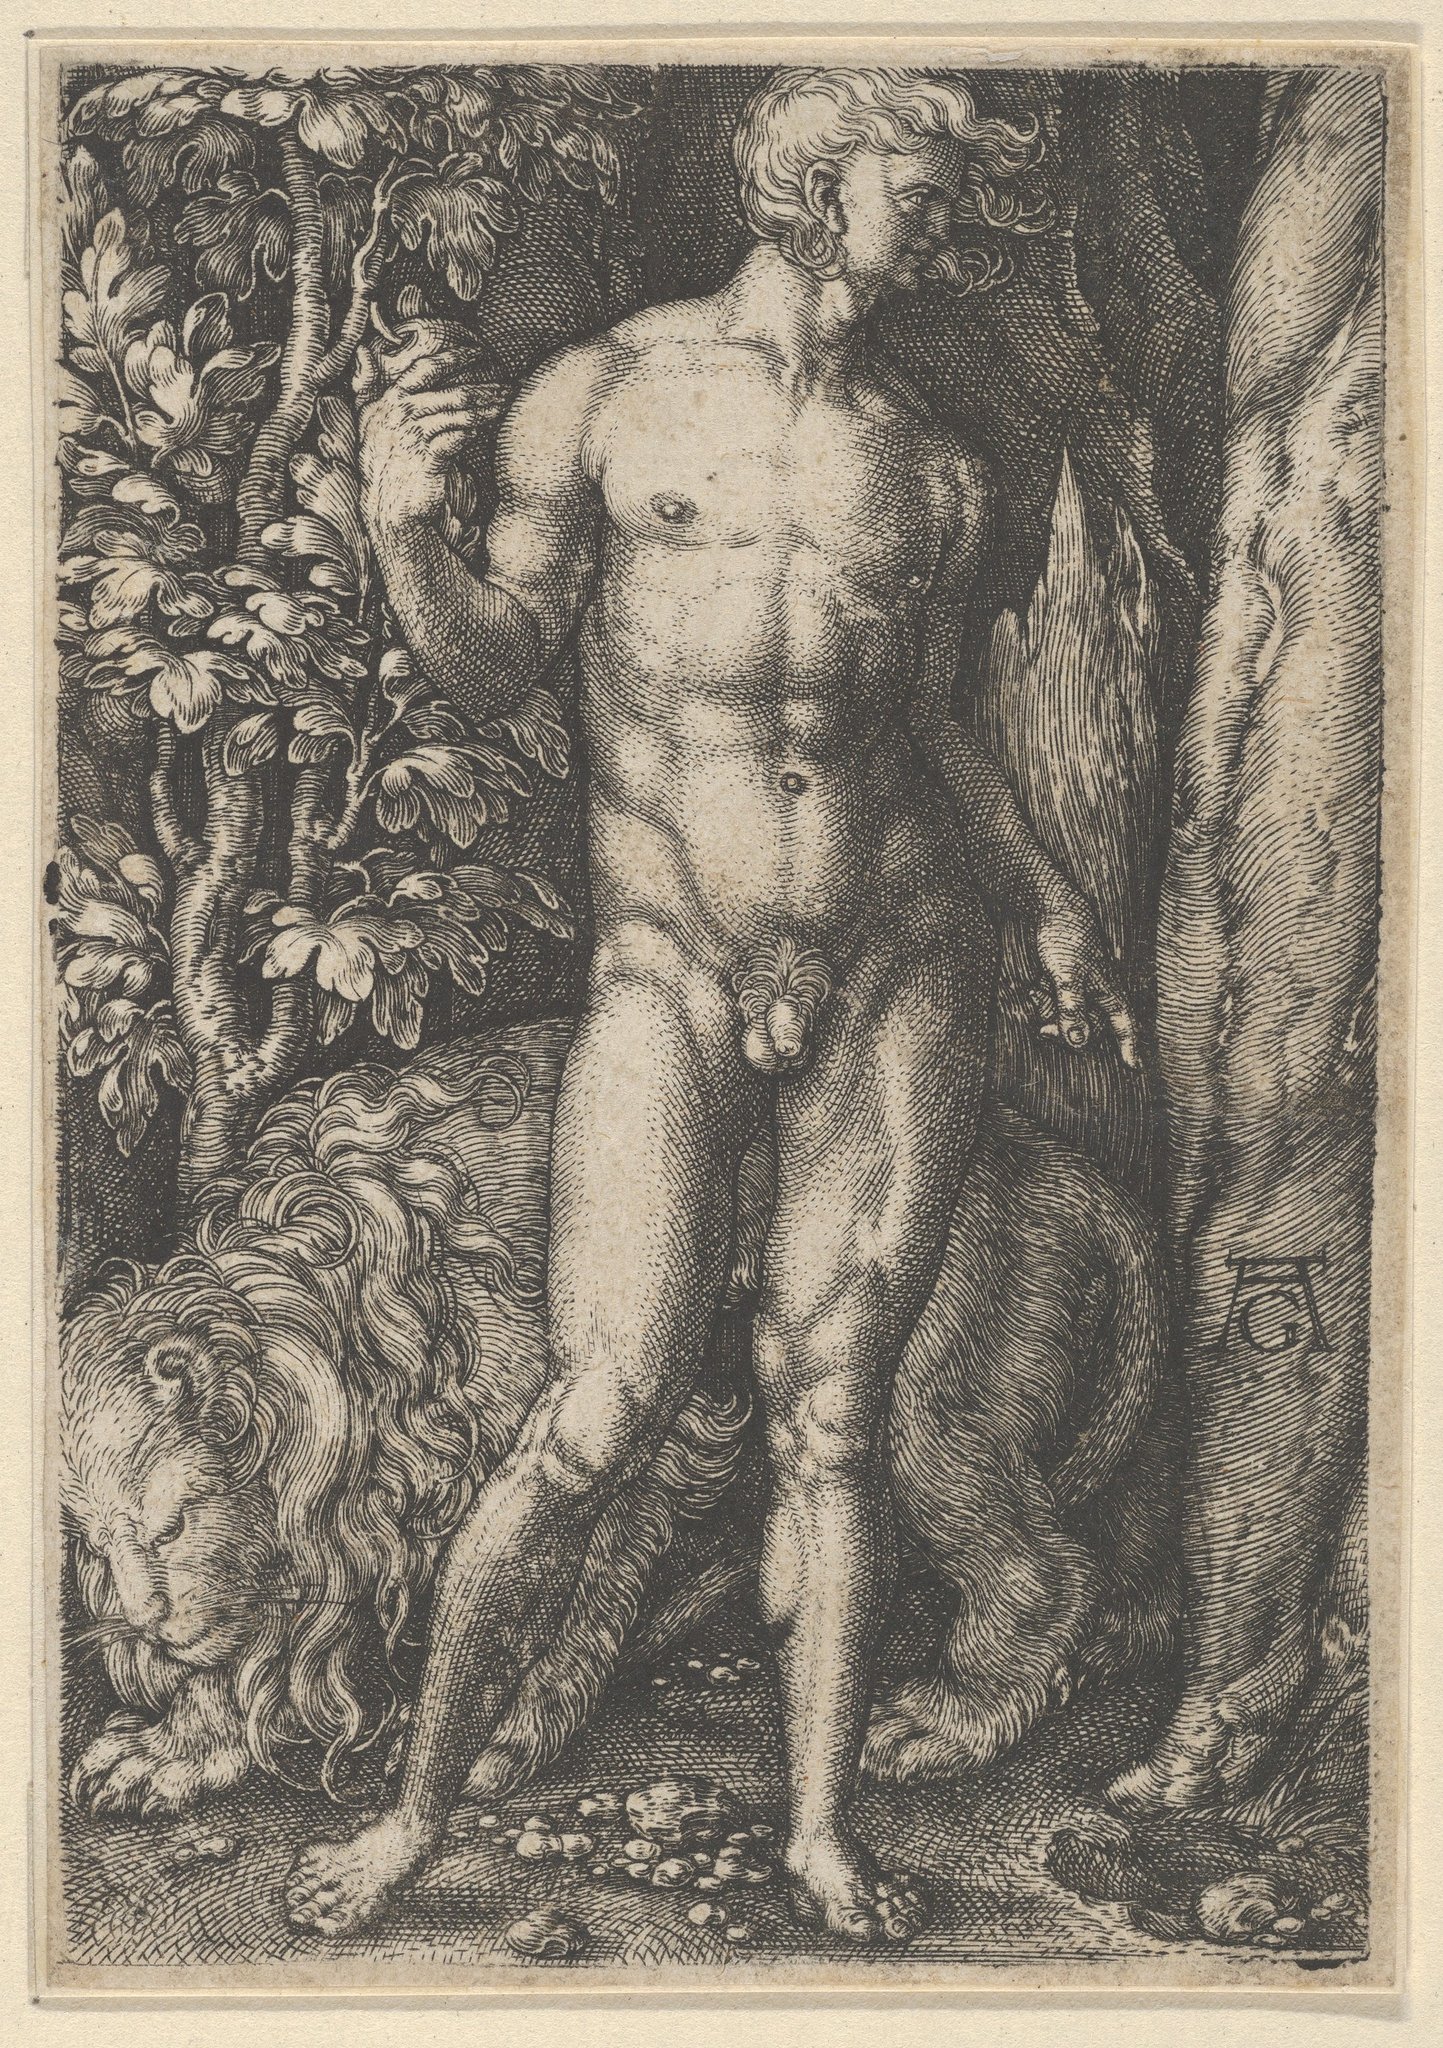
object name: print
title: Adam with a Lion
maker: heinrich aldegrever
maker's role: artist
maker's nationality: german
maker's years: 1502-1561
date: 1501-1600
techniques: engraving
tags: lions,adam